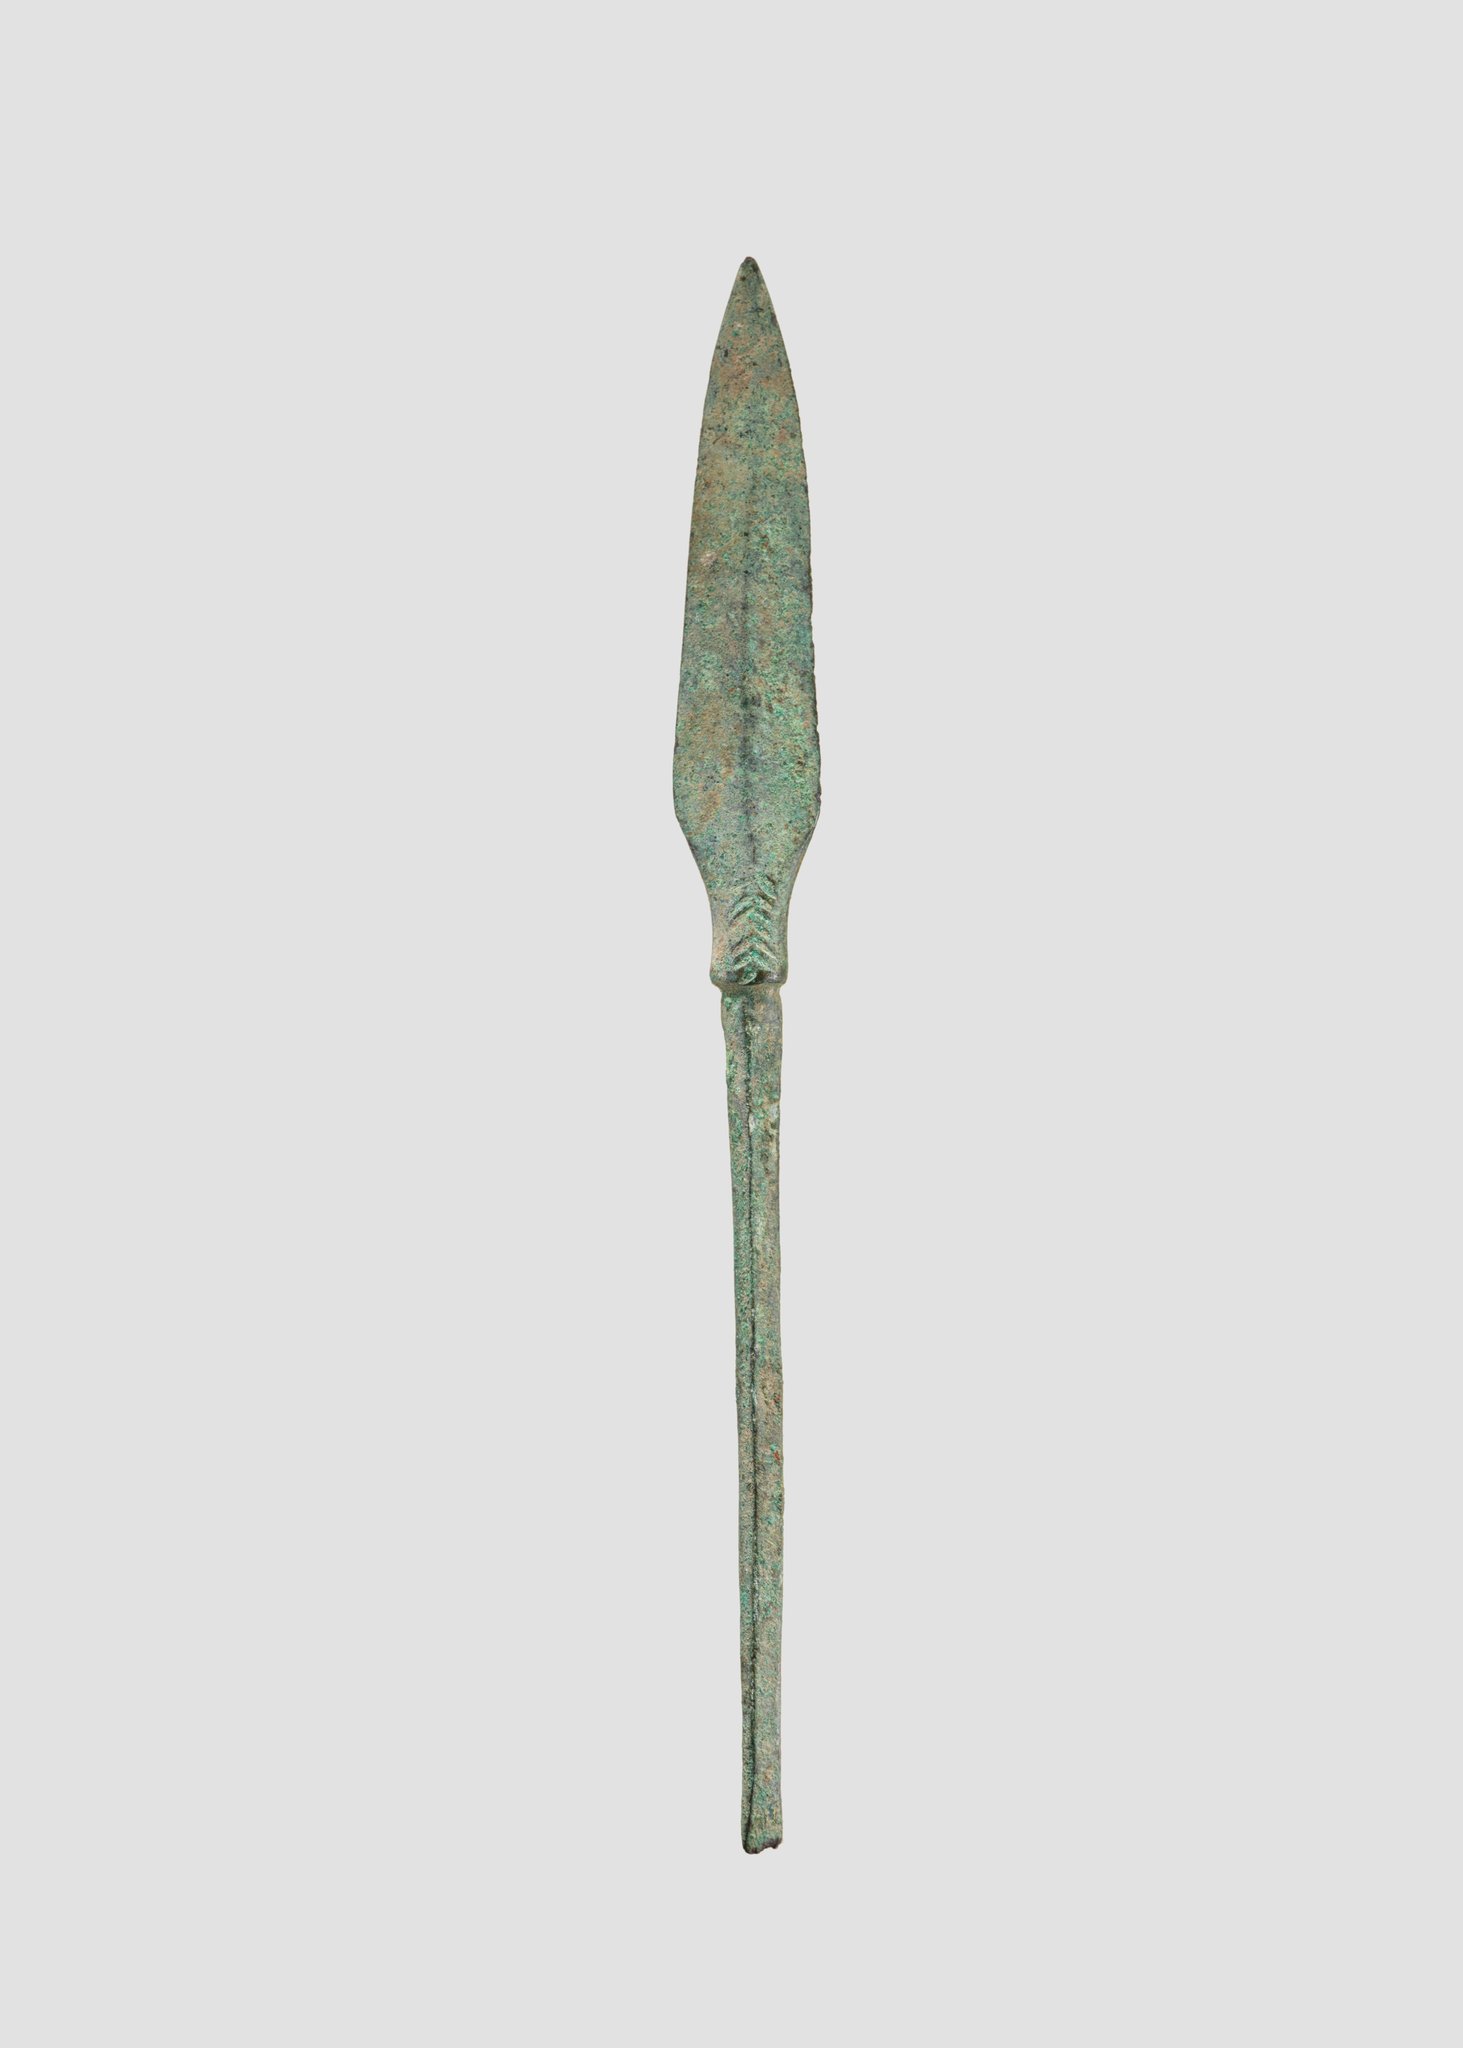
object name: arrowhead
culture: iranian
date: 2000-1 BCE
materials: bronze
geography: iran